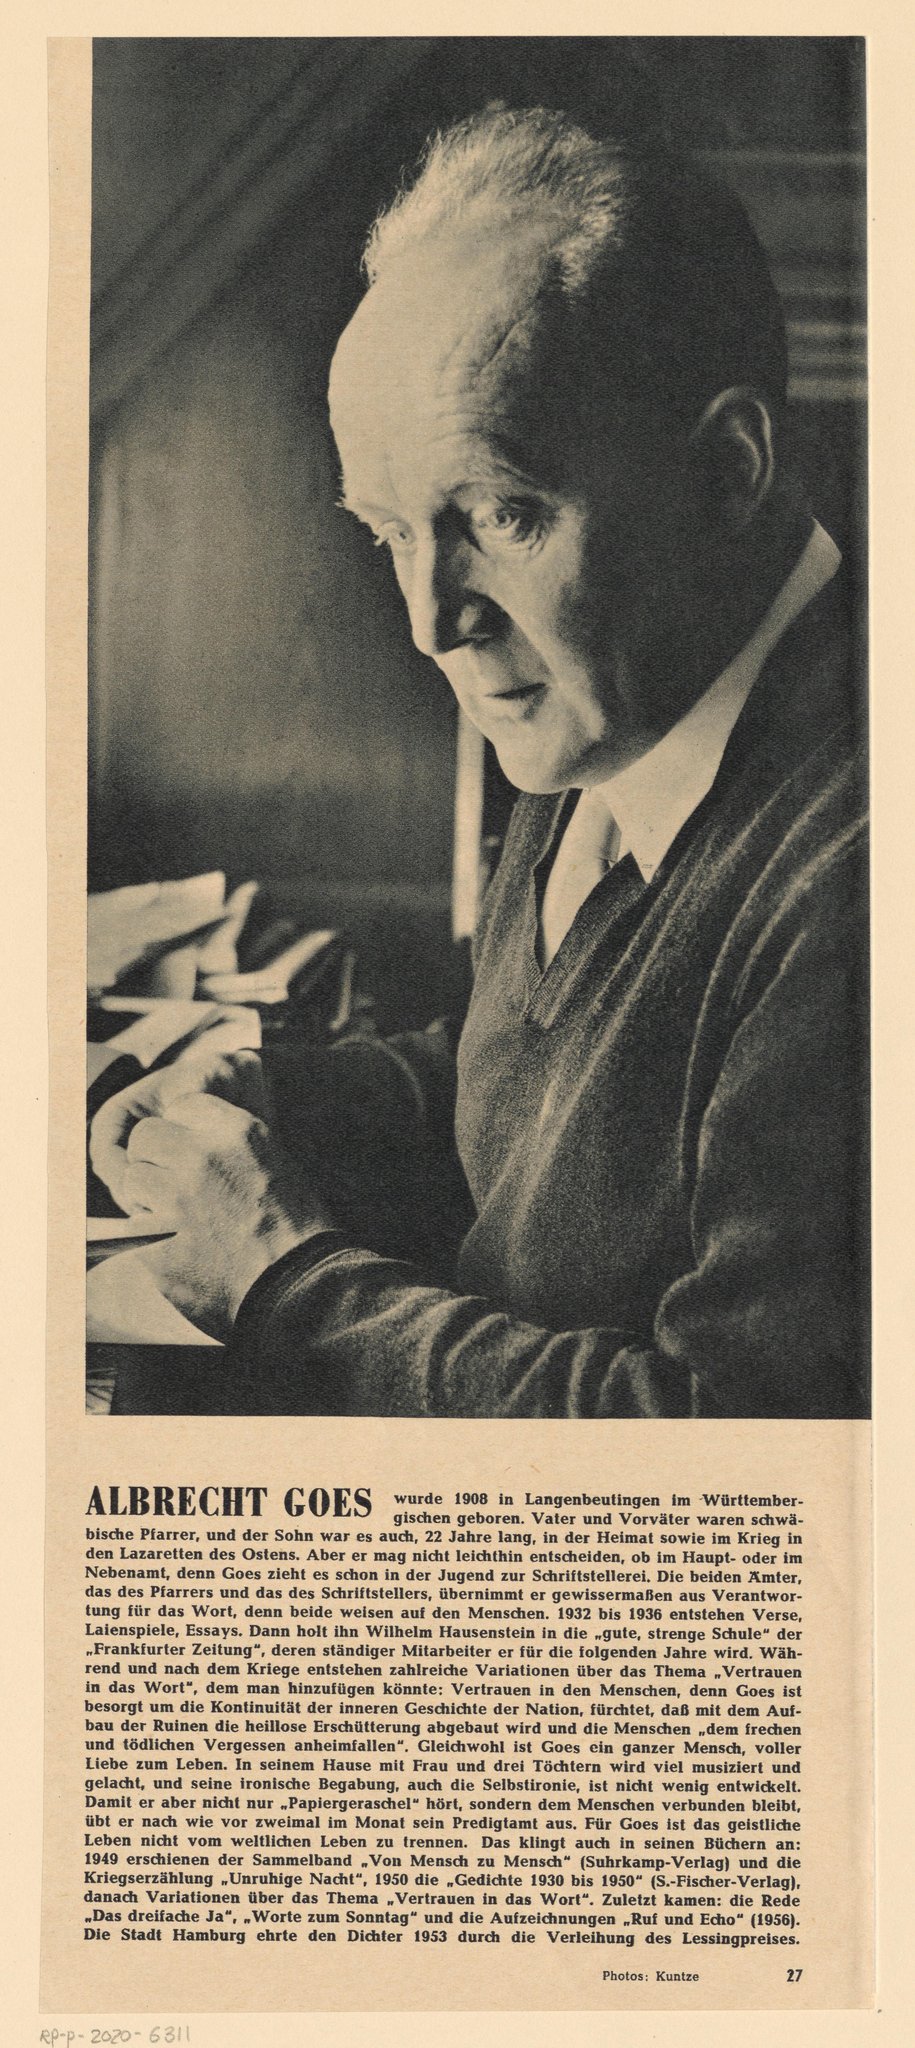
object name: photomechanical print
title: Portret van Albrecht Goes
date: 1956-1980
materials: paper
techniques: letterpress printing, rotogravure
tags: historical persons, writer, poet, author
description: Prent uit een onbekende editie van de periodiek Kunstspiegel na 1956.